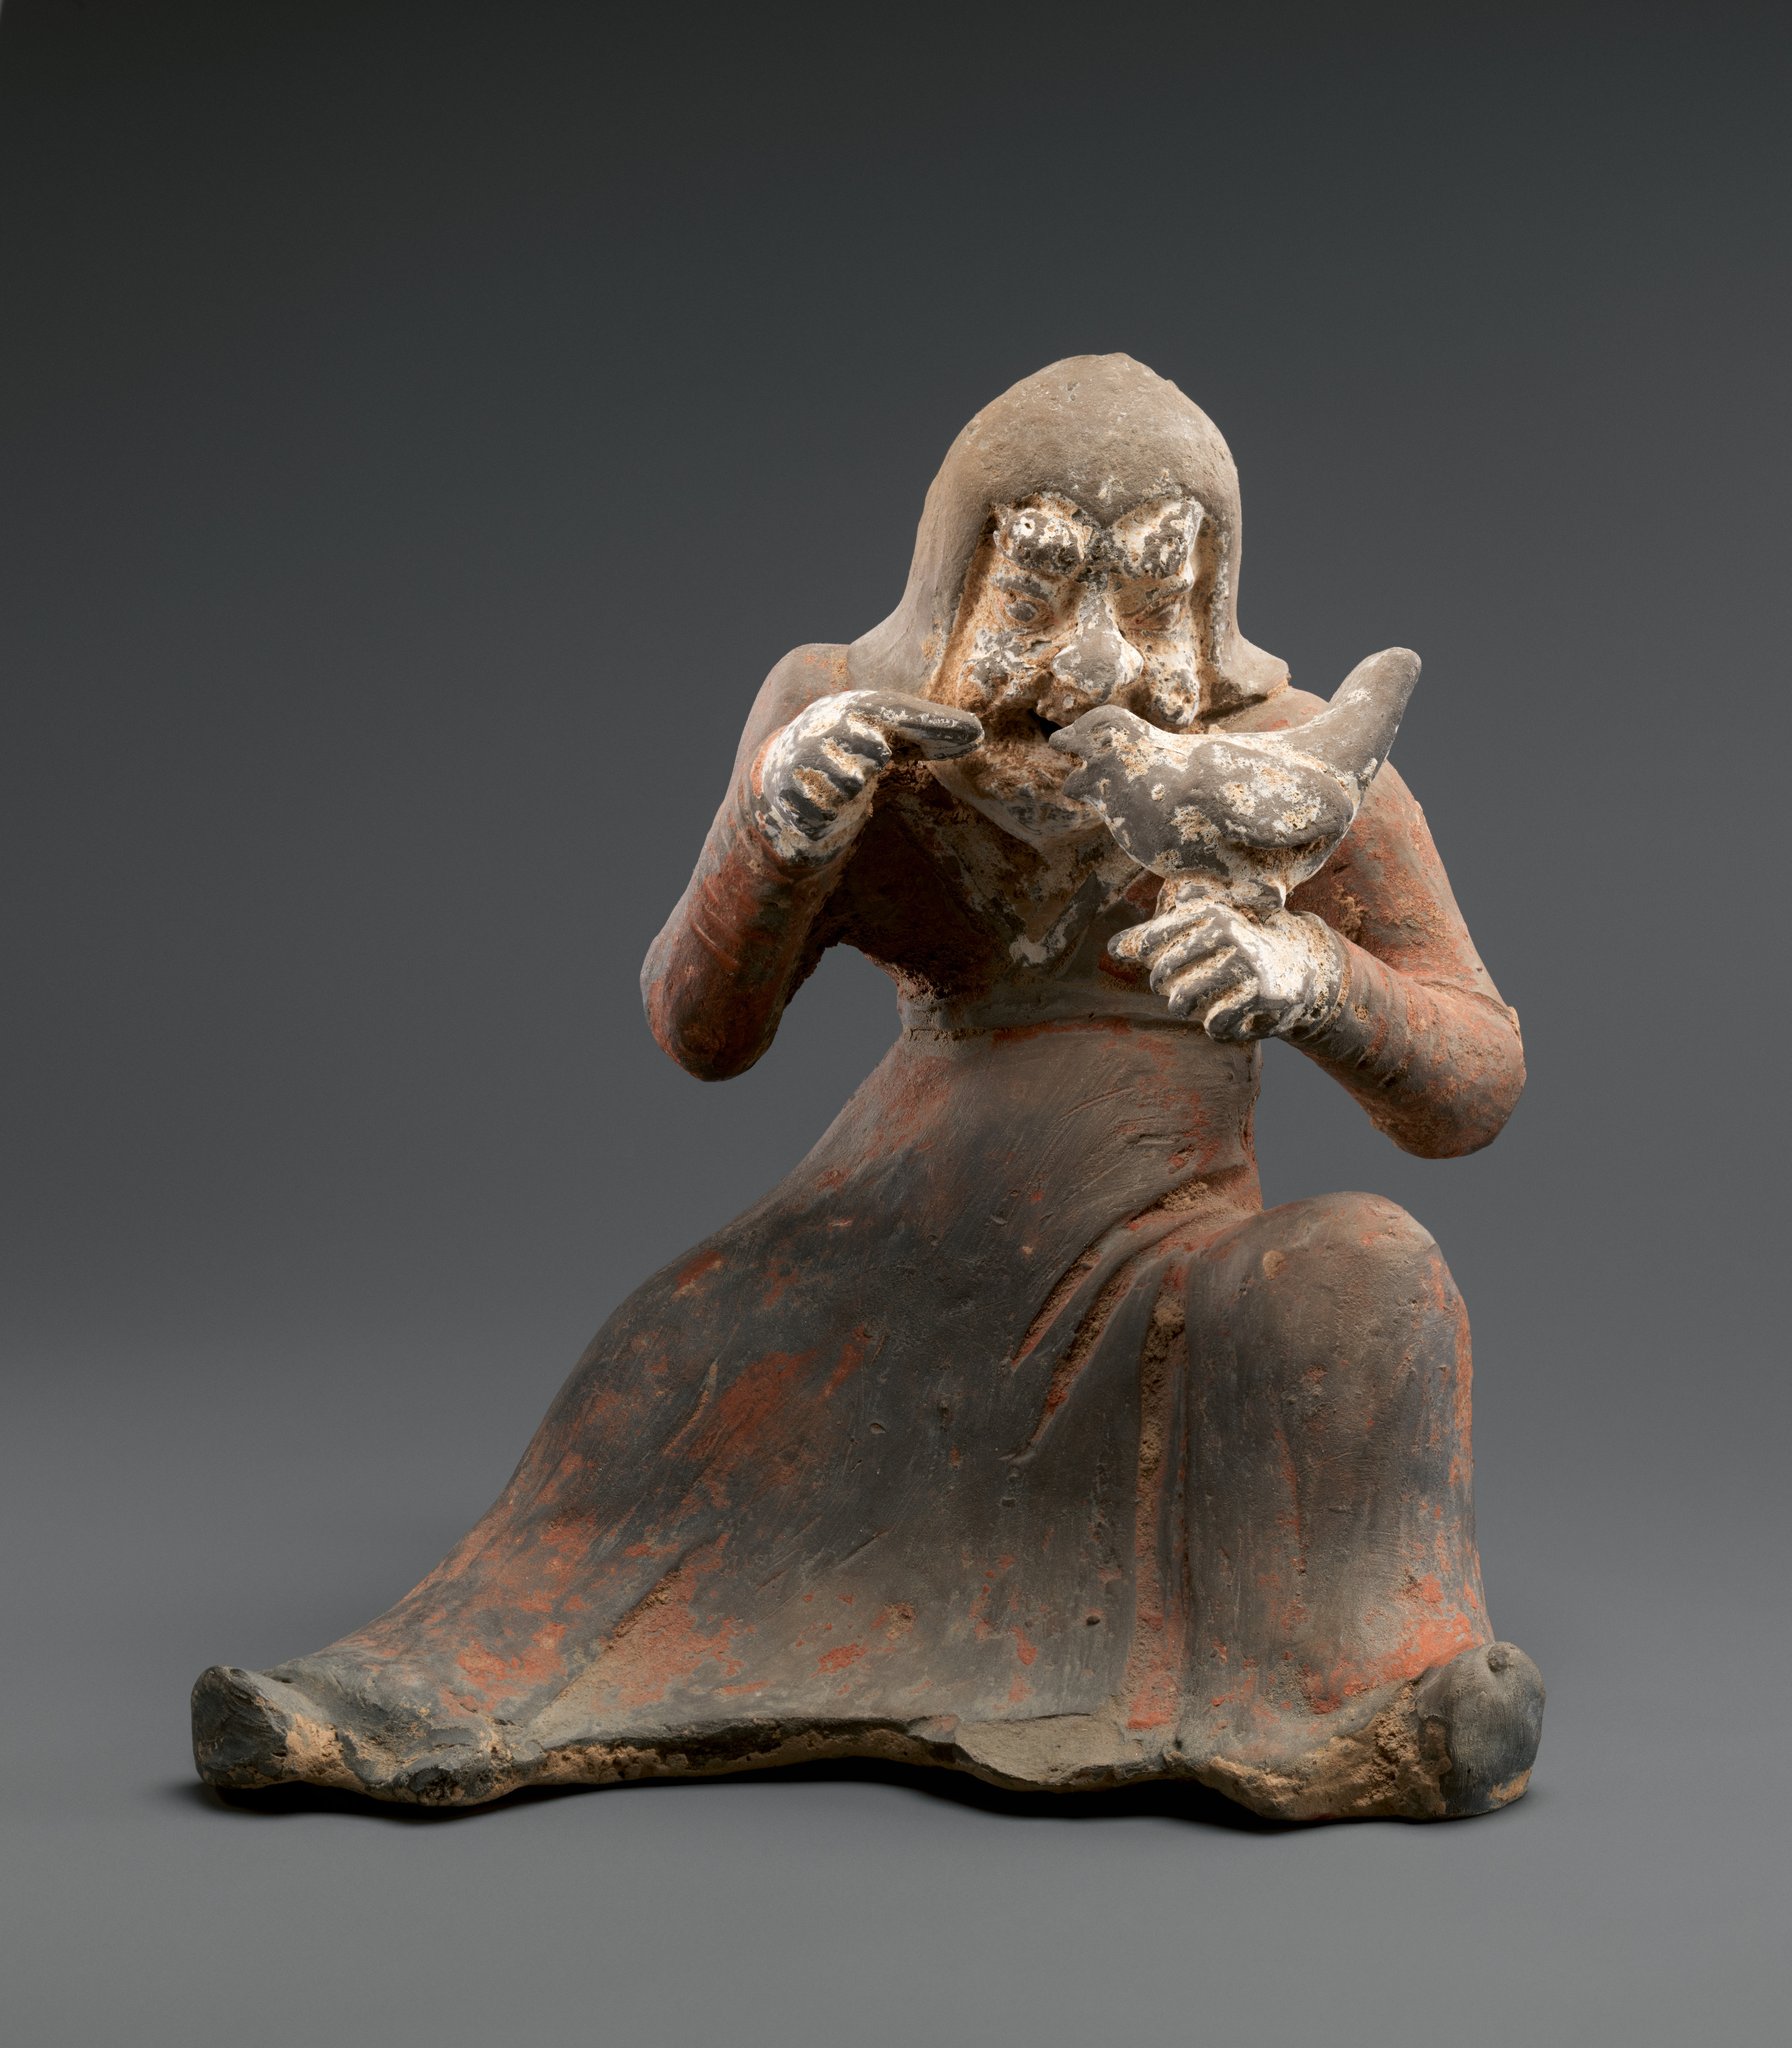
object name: one of a pair of figure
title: Seated Falconer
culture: chinese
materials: earthenware, pigment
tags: falcons,men